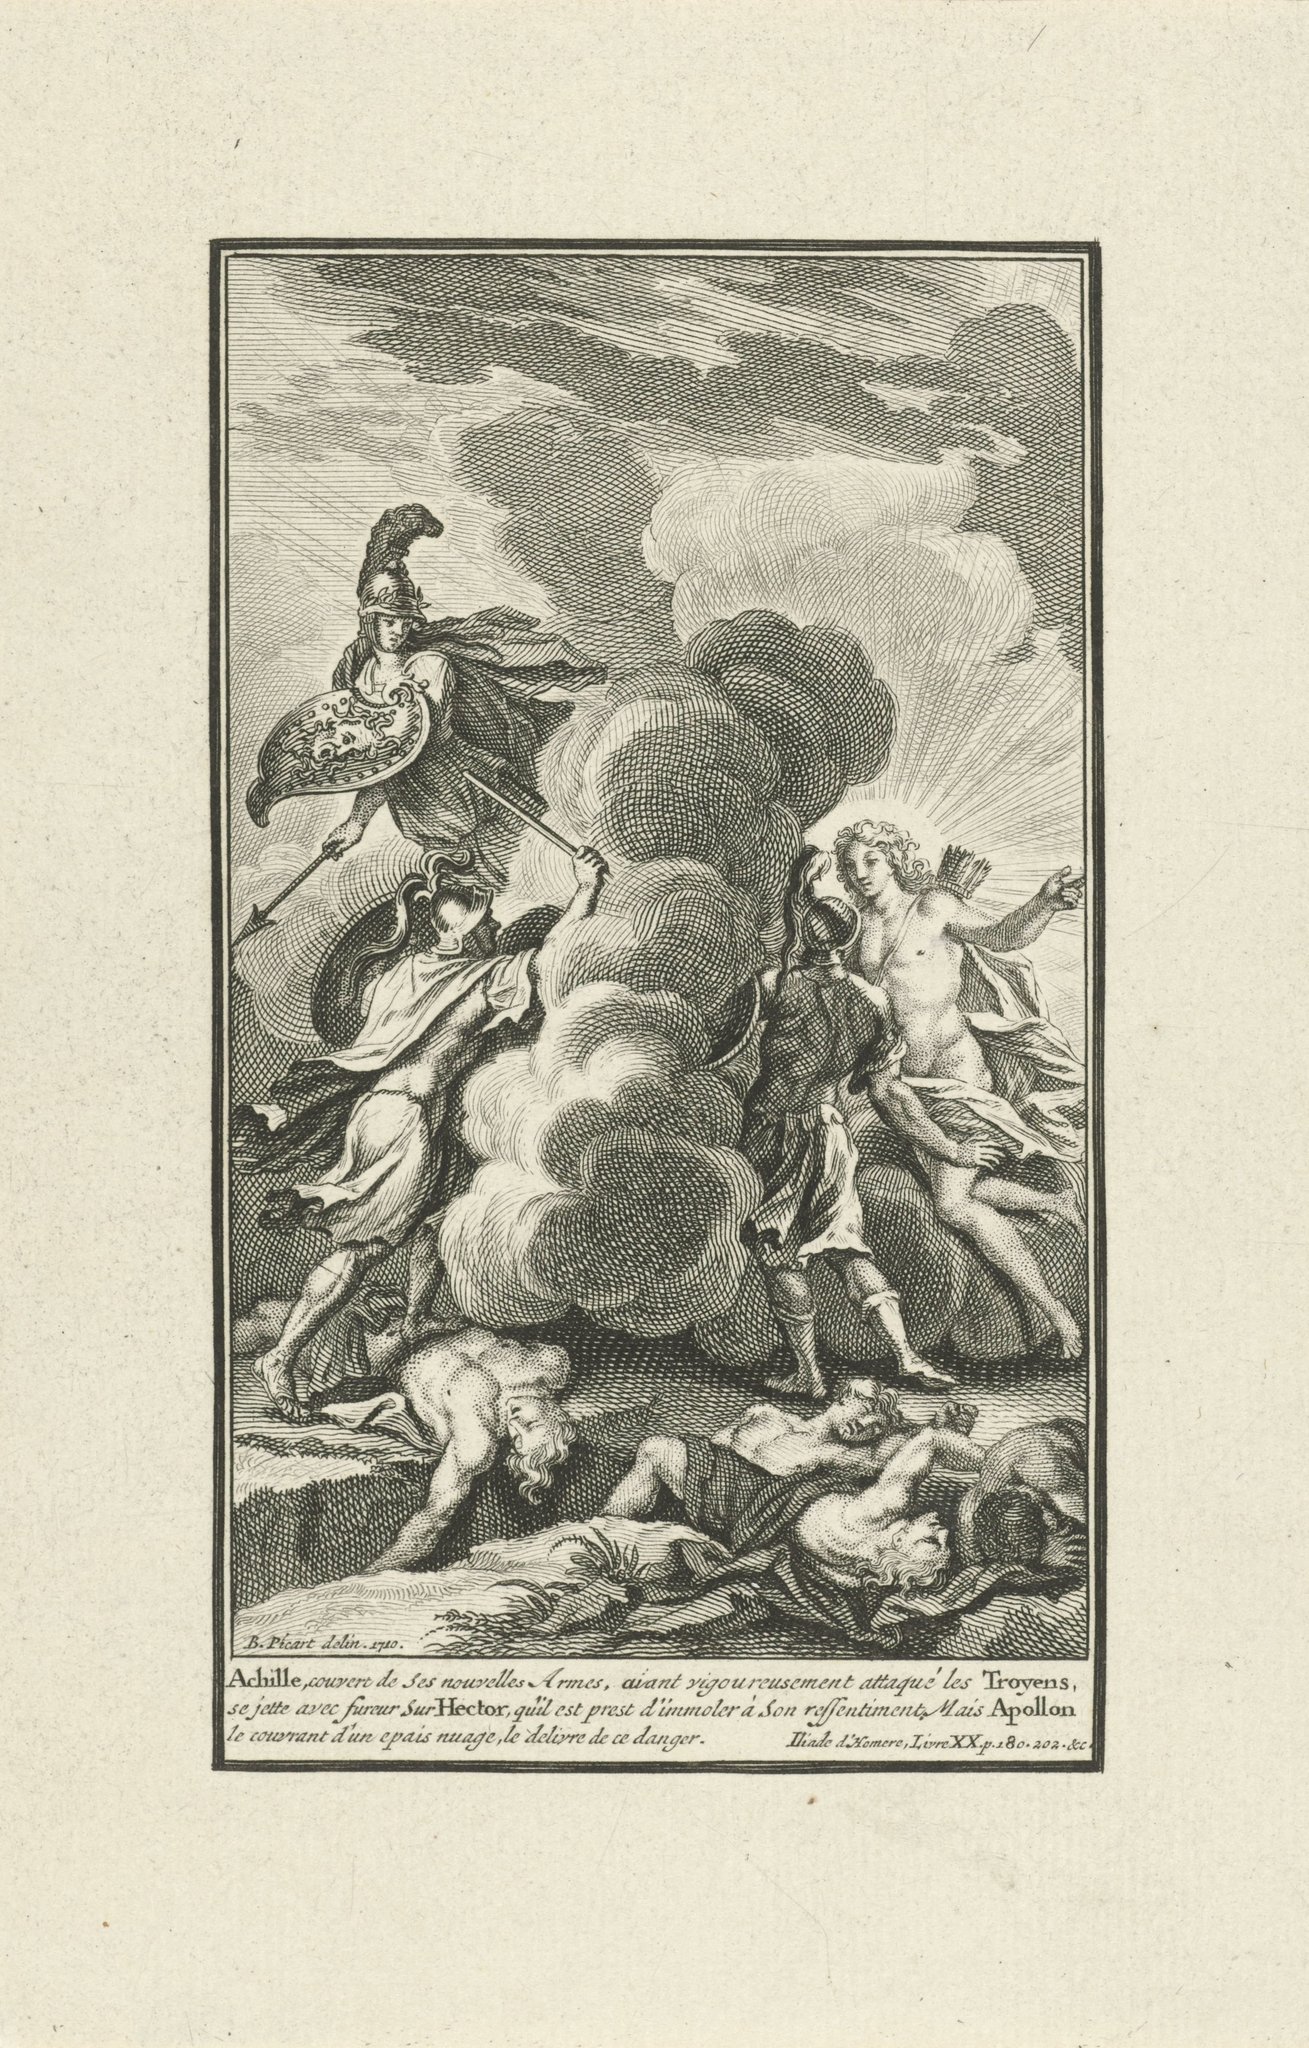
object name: book illustration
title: Gevecht tussen Achilles en Hector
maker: bernard picart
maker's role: draughtsman, print maker, publisher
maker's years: 1673-1733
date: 1710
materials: paper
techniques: engraving, etching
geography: amsterdam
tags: the tenth year of the trojan war (part ii): achilles back to war; his last deeds and his death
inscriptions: collector's mark: Lugt 2228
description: Achilles draagt zijn nieuwe wapenrusting en vecht met Hector. Minerva strijdt met hem mee. Hector wordt echter beschermd door Apollo, die vecht aan de Trojaanse kant en hem in een wolk hult om hem te beschermen. In de marge een onderschrift in het Frans.